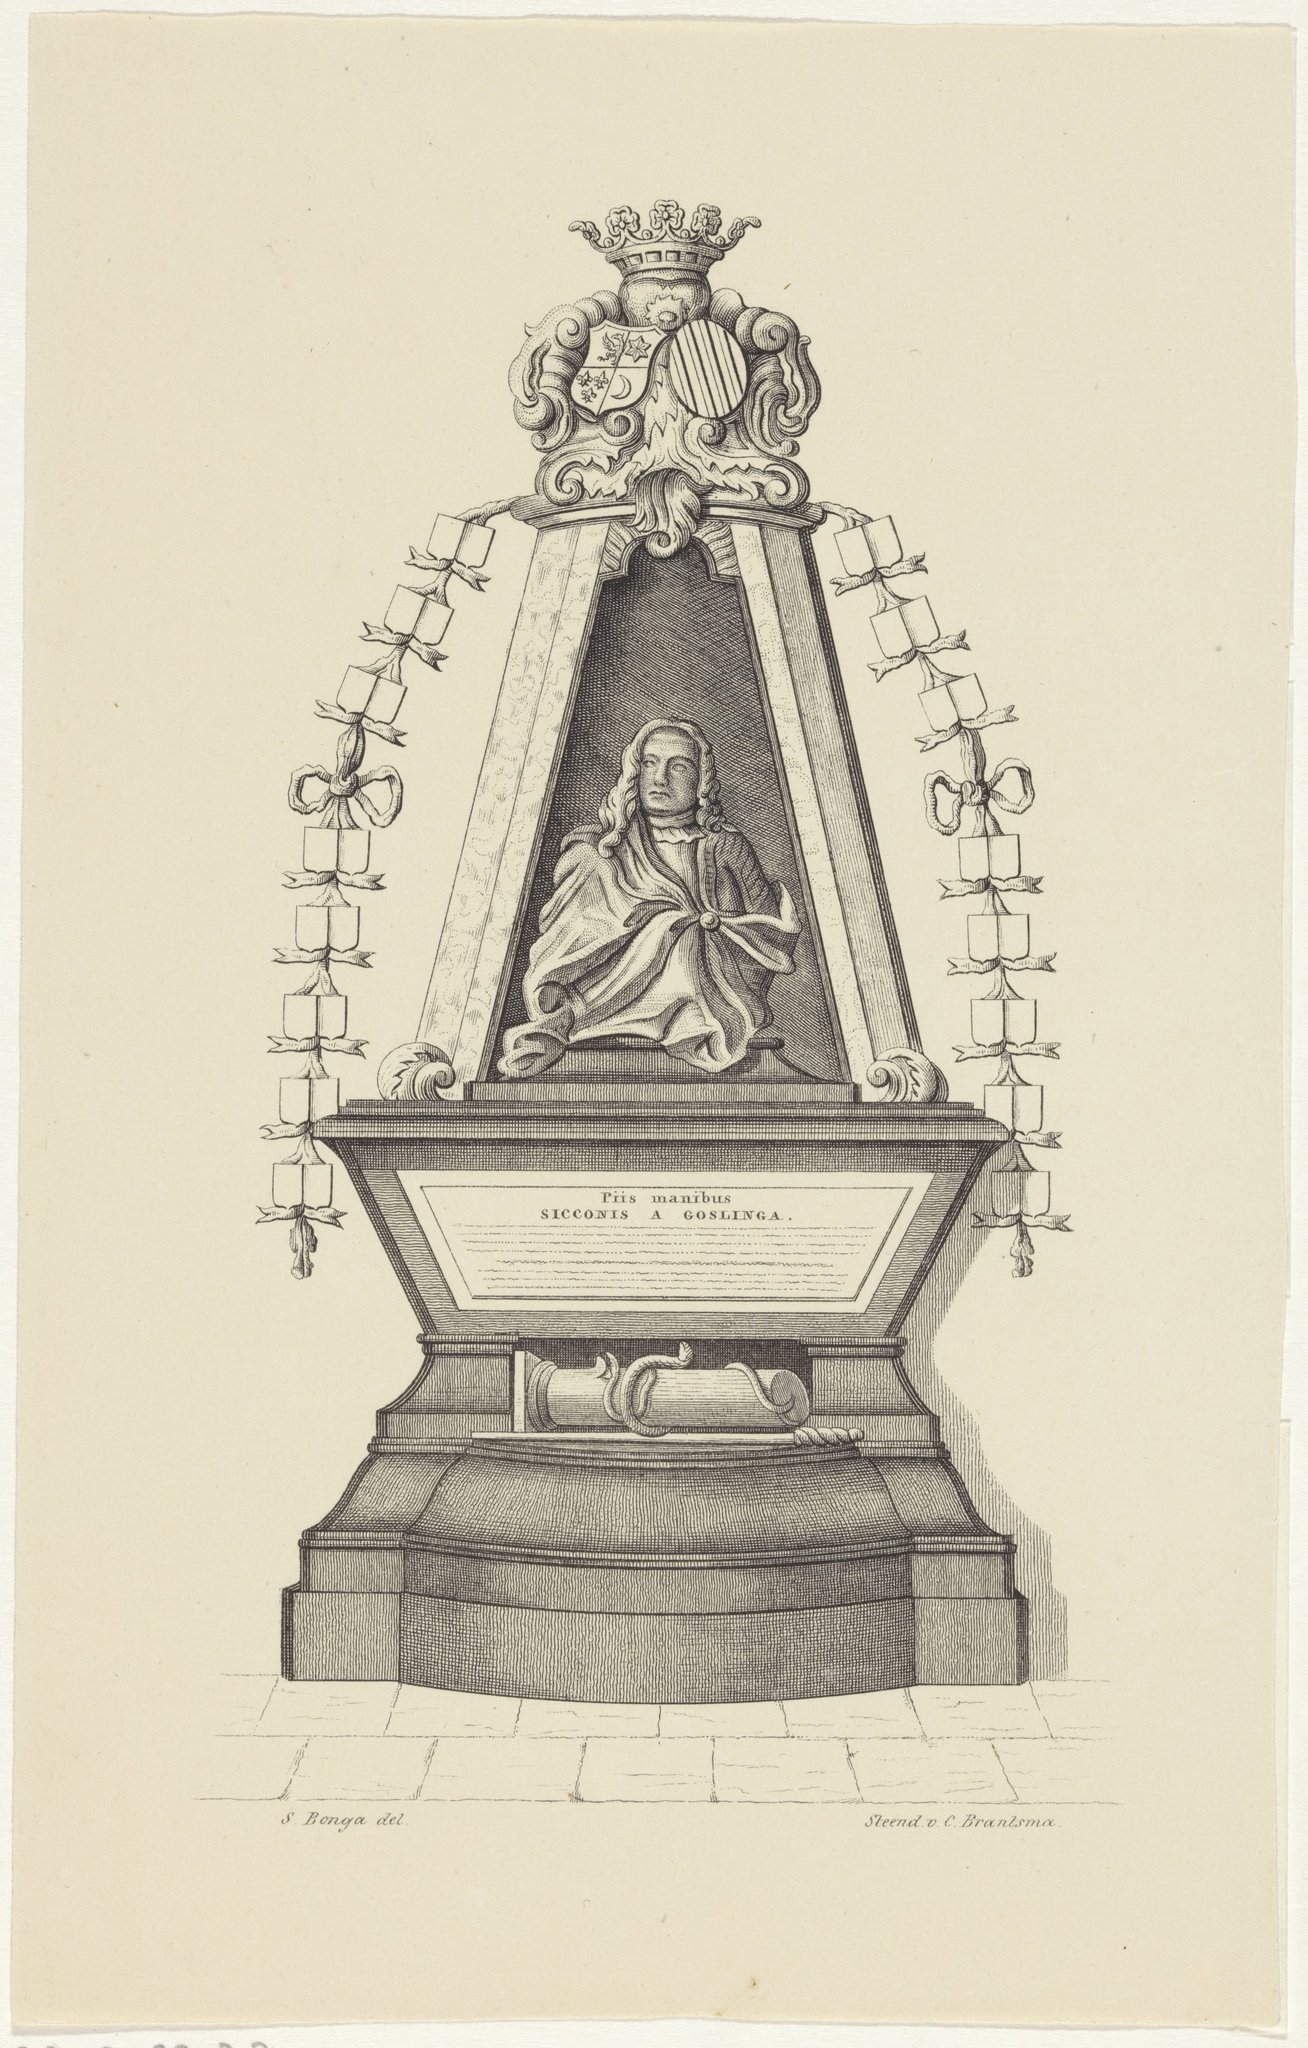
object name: print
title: Grafmonument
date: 1822-1847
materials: paper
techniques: lithograph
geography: leeuwarden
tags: niche-tomb, wall-tomb, piece of sculpture, reproduction of a piece of sculpture, armorial bearing, heraldry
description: Onder het grafschrift ligt een gebroken zuil met daar omheen een slang, onder de zuil ligt een zwaard. Op de tombe staat een portretbuste. Bovenin twee familiewapens. Links en rechts van het monument hangt een lint met daaraan lege familiewapens.